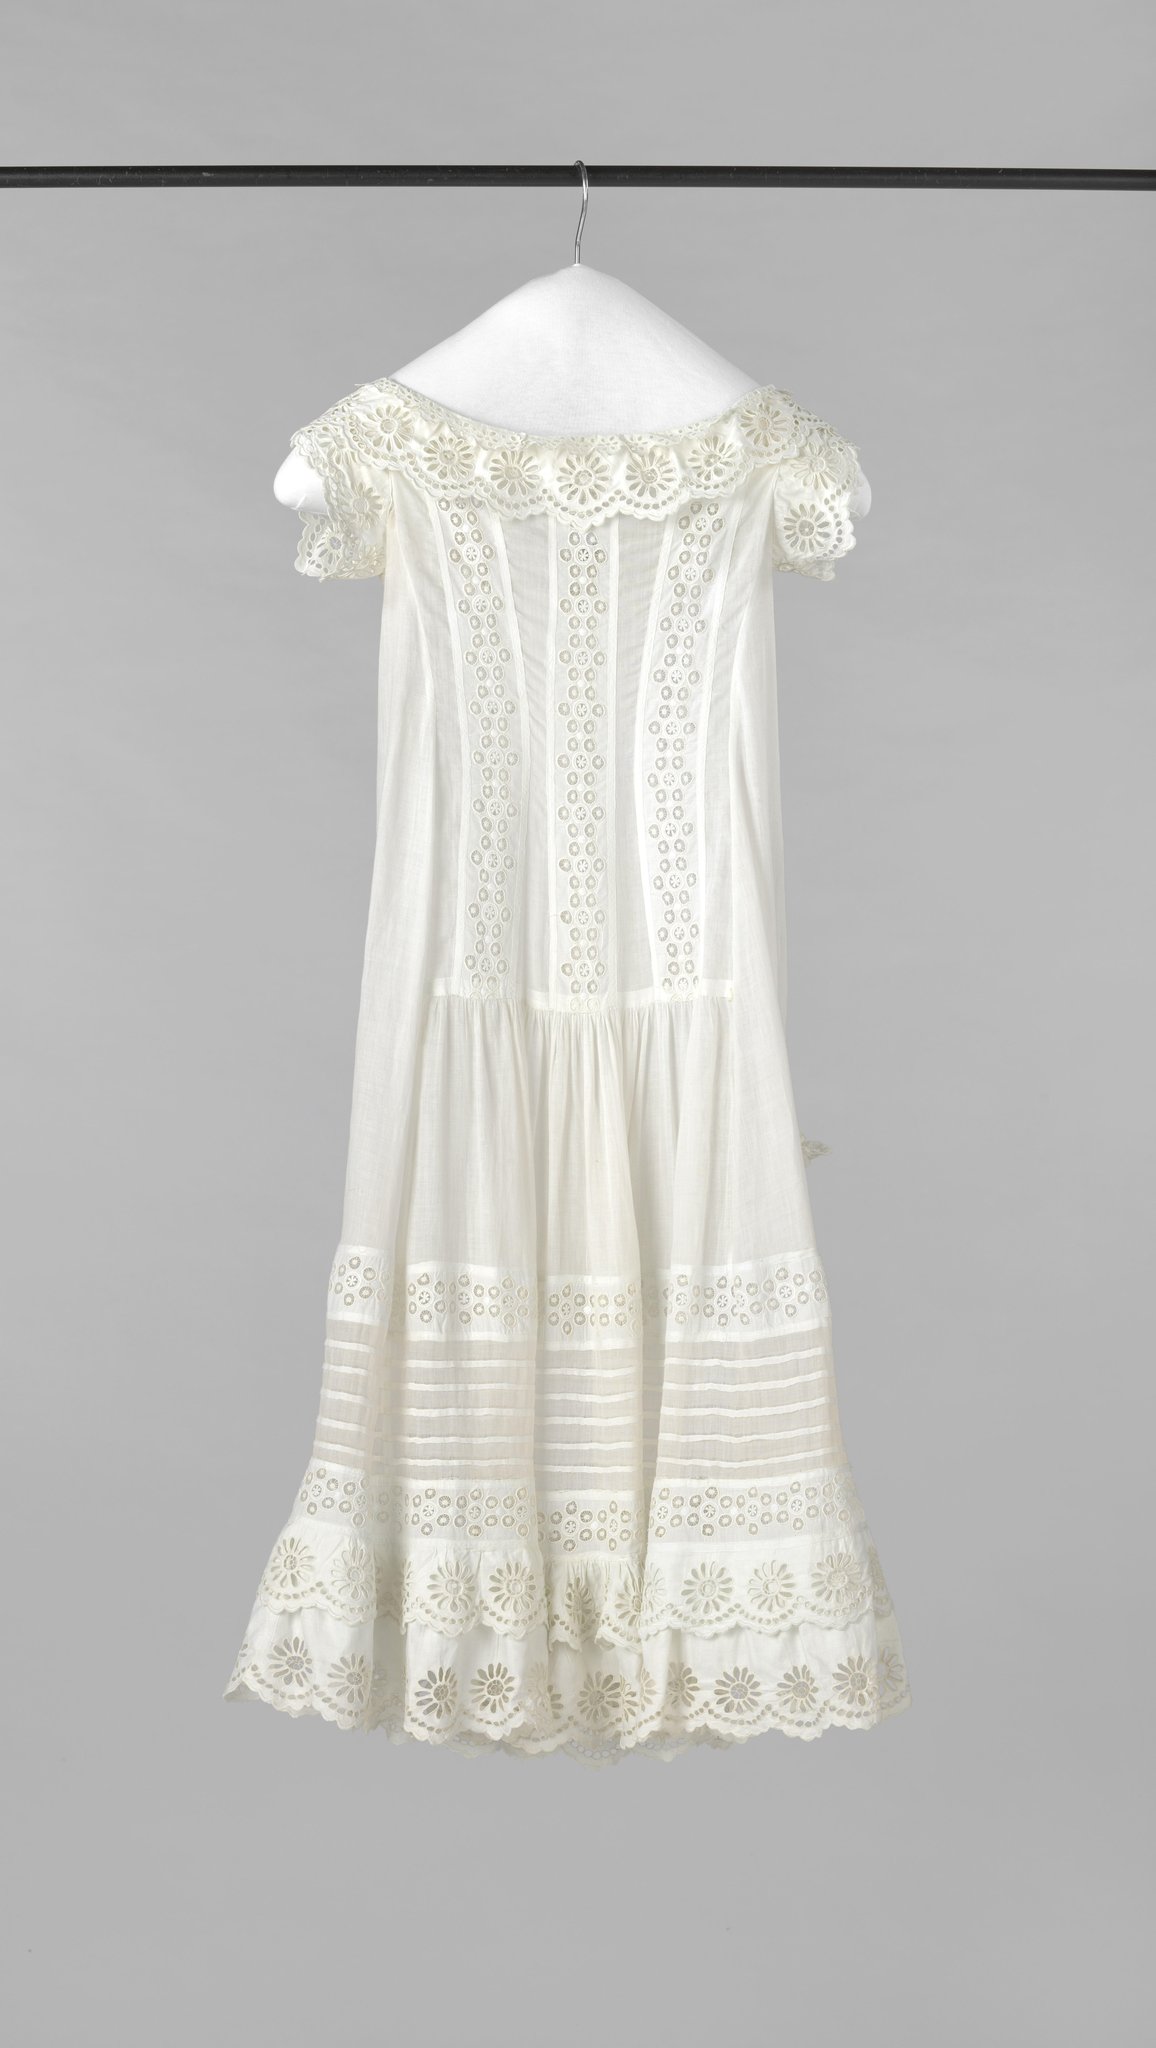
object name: robe, japon, jurk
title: Japon met voorsluiting met acht knopen en glad aangezette strook als mouw van batist met tussenzetsels van Engels borduurwerk; rok voor glad, achter ruim gerimpeld als queue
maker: Anonymous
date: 1883-1885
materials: textile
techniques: embroidered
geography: amsterdam